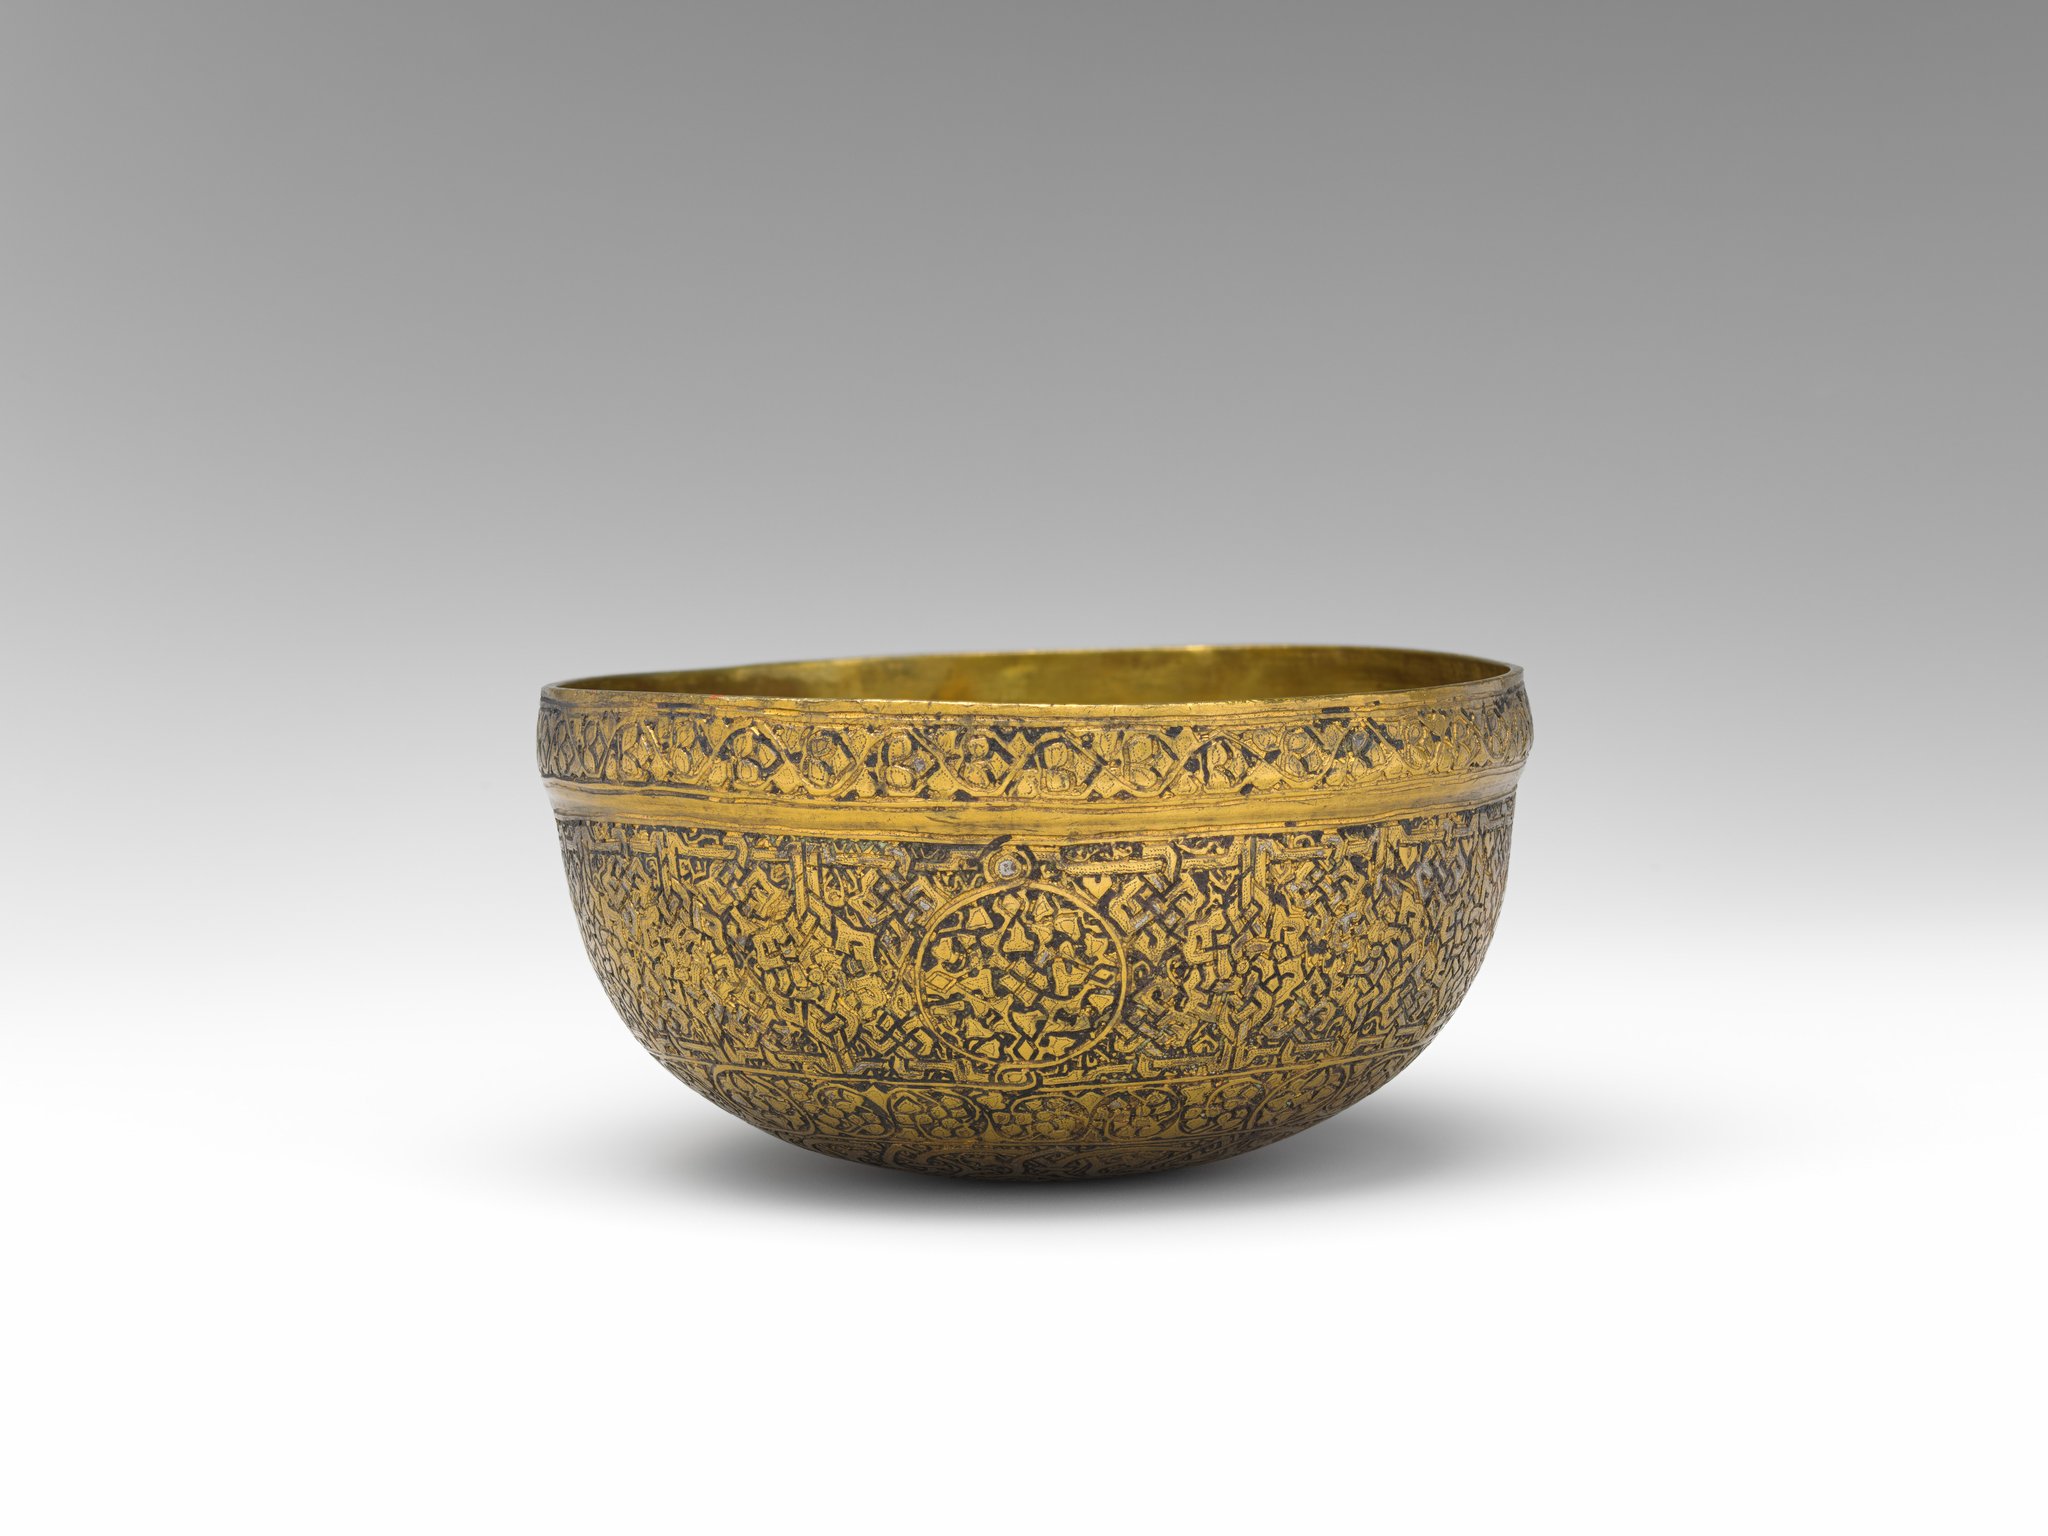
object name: bowl with cover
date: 1401-1500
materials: brass, silver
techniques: inlay